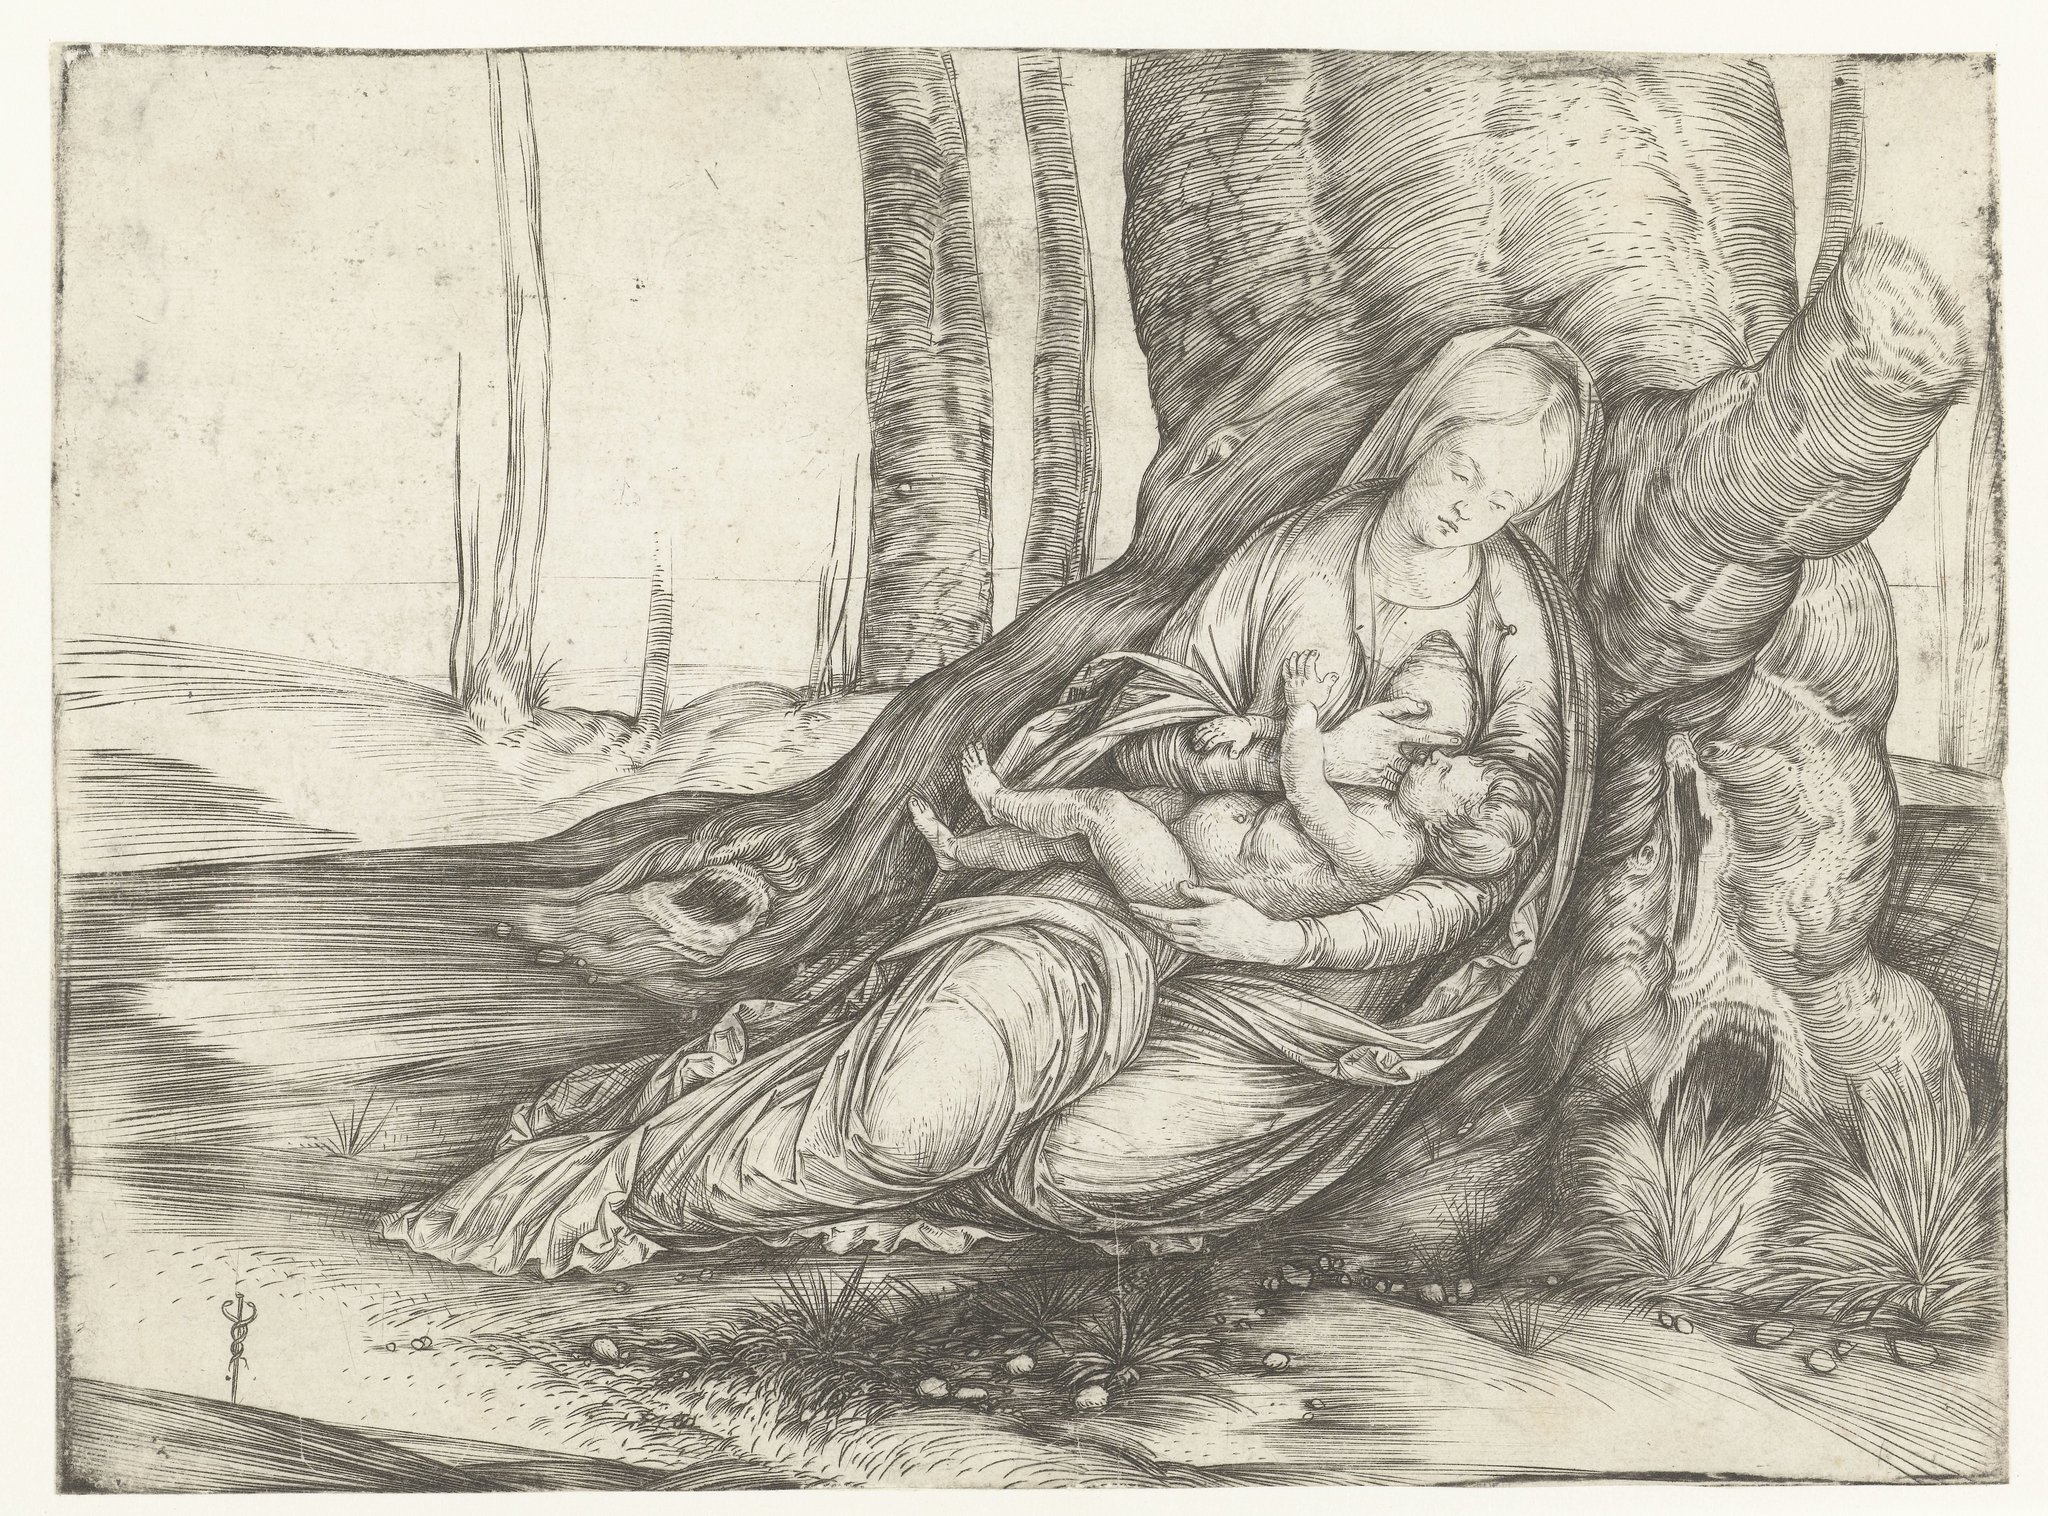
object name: print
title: Maria met kind aan borst zit voor voet van boom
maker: jacopo de barbari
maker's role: draughtsman, print maker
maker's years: 1440-1516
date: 1498-1503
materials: paper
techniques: engraving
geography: italy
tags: christ-child suckling, or beginning to suckle, e.g. mary uncovering her breast ~ madonna-representations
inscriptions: collector's mark: Lugt 240